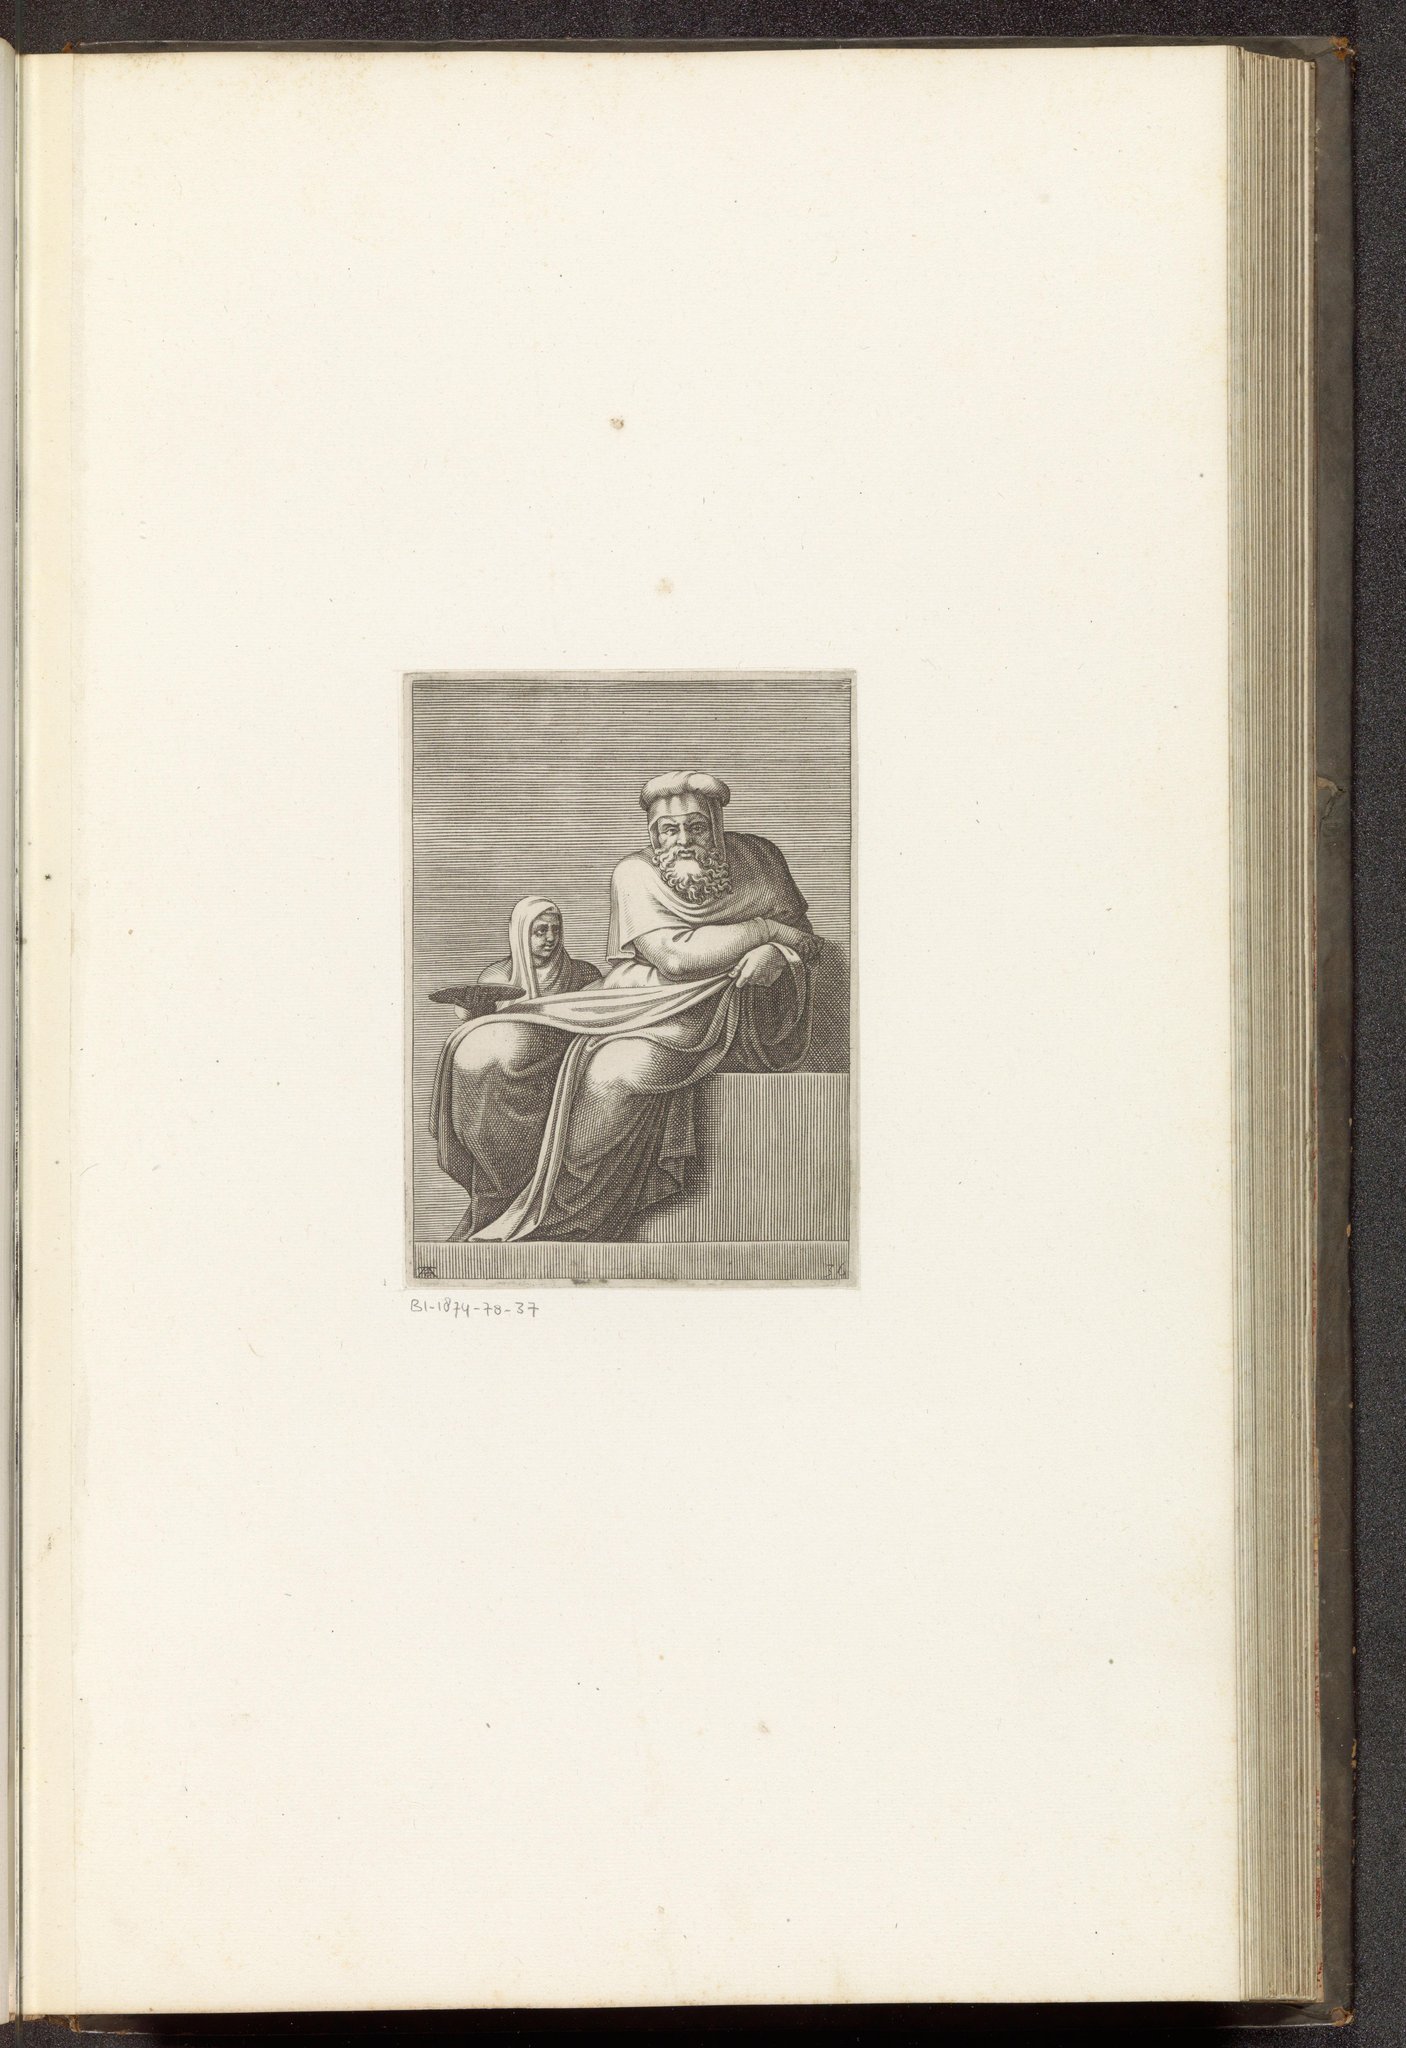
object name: album leaf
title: Schilderingen in de Sixtijnse kapel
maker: adamo scultori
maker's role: painter, print maker, sculptor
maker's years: 1530-1585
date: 1585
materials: paper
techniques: engraving, intaglio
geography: italy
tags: house personnel, servants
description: Een bebaarde zittende man met links een bediende. Figuren afkomstig van Michelangelo's plafondschildering. Genummerd rechtsonder: 36. De prent maakt deel uit van een album.